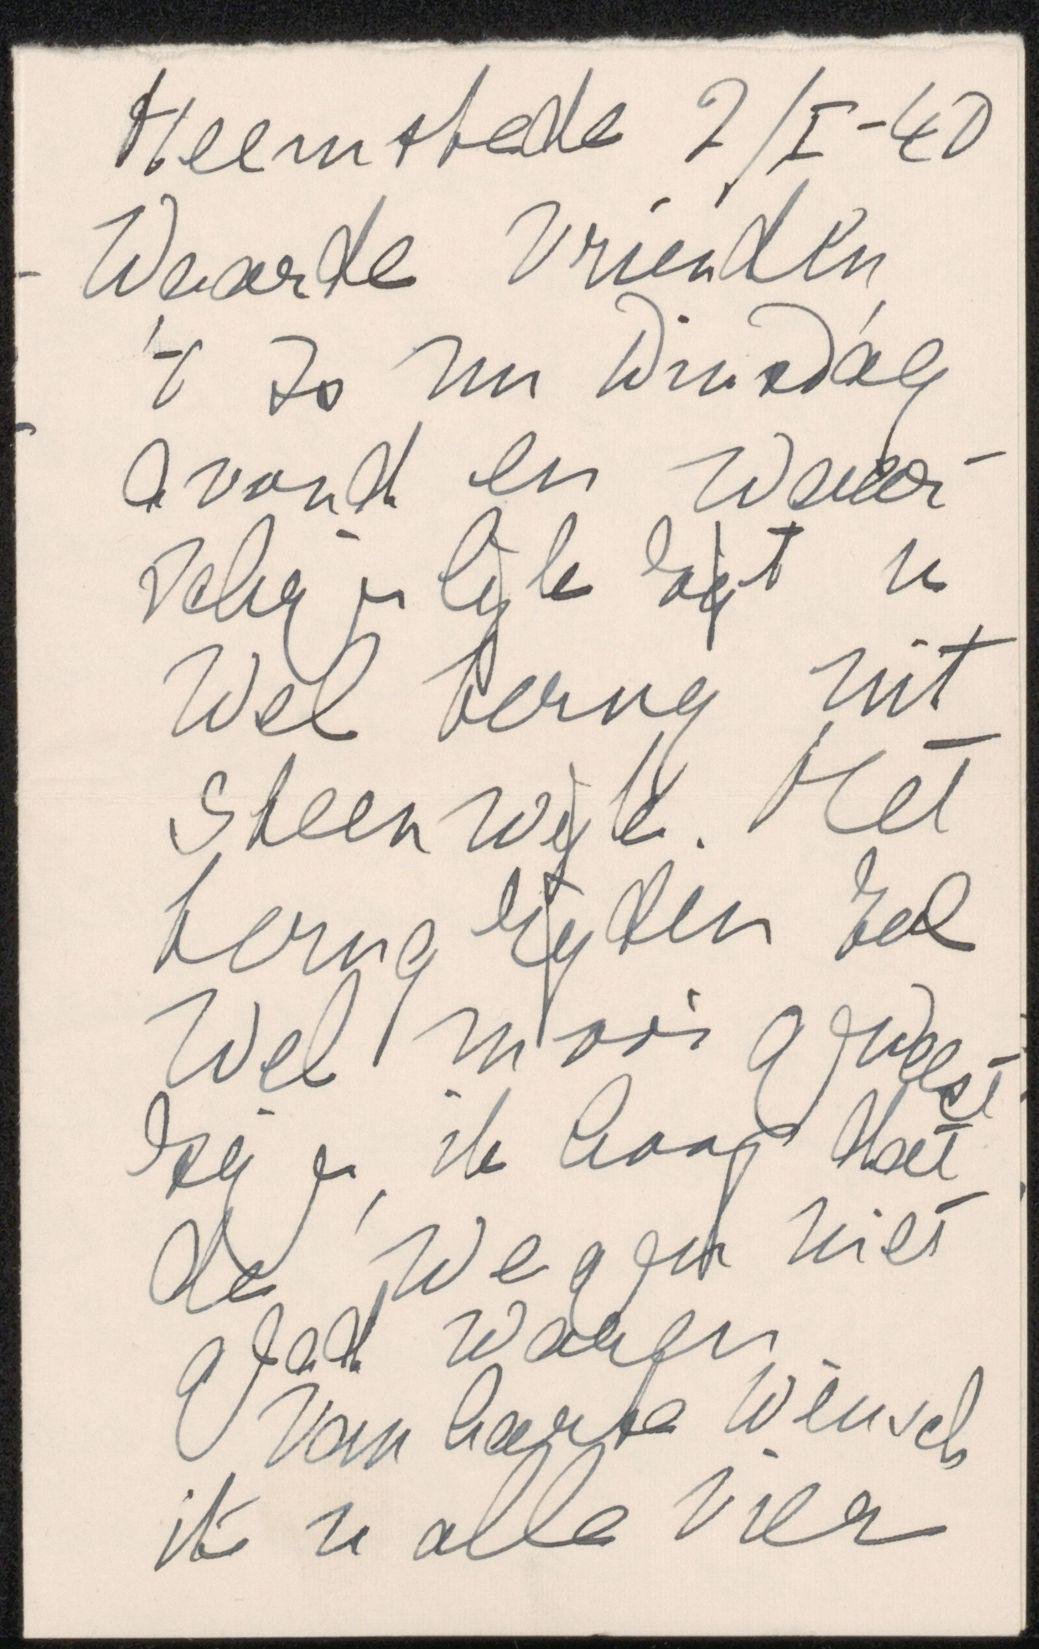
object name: letter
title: Brief aan Willem Bogtman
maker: henriëtte roland holst-van der schalk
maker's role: dichter, schrijver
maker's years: 1869-1952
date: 1940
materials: ink, paper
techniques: pen, writing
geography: heemstede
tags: ab bogtman, print maker, toos bogtman, haarlem, willem bogtman, richard nicolaüs roland holst